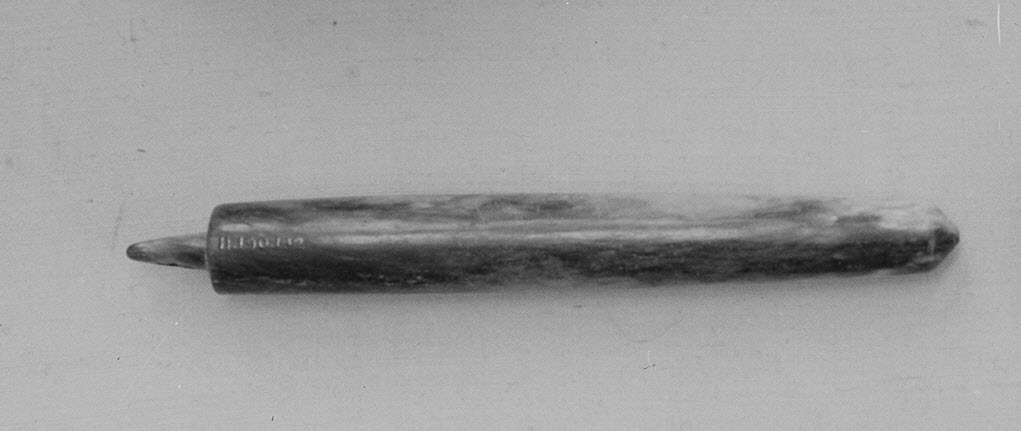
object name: pendant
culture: chinese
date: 3200-2000 BCE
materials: jade